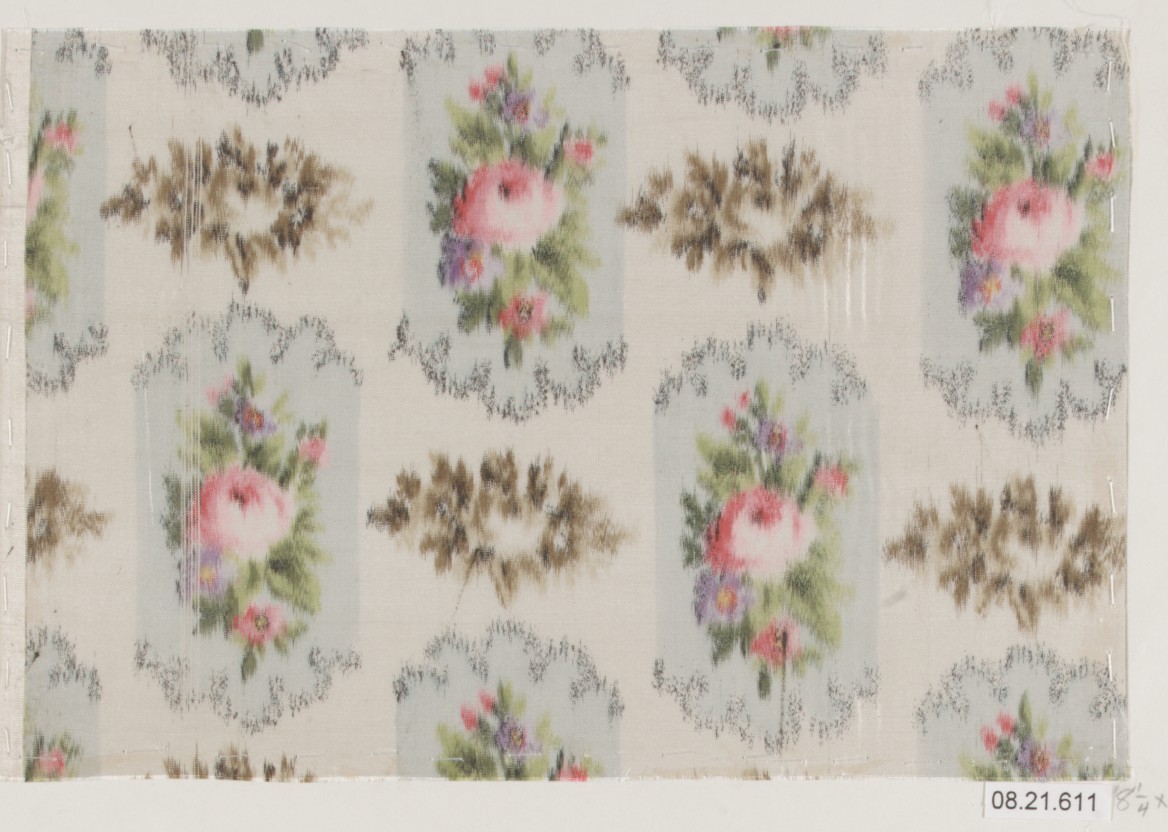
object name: textile sample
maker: Anonymous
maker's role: designer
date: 1900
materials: silk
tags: flowers